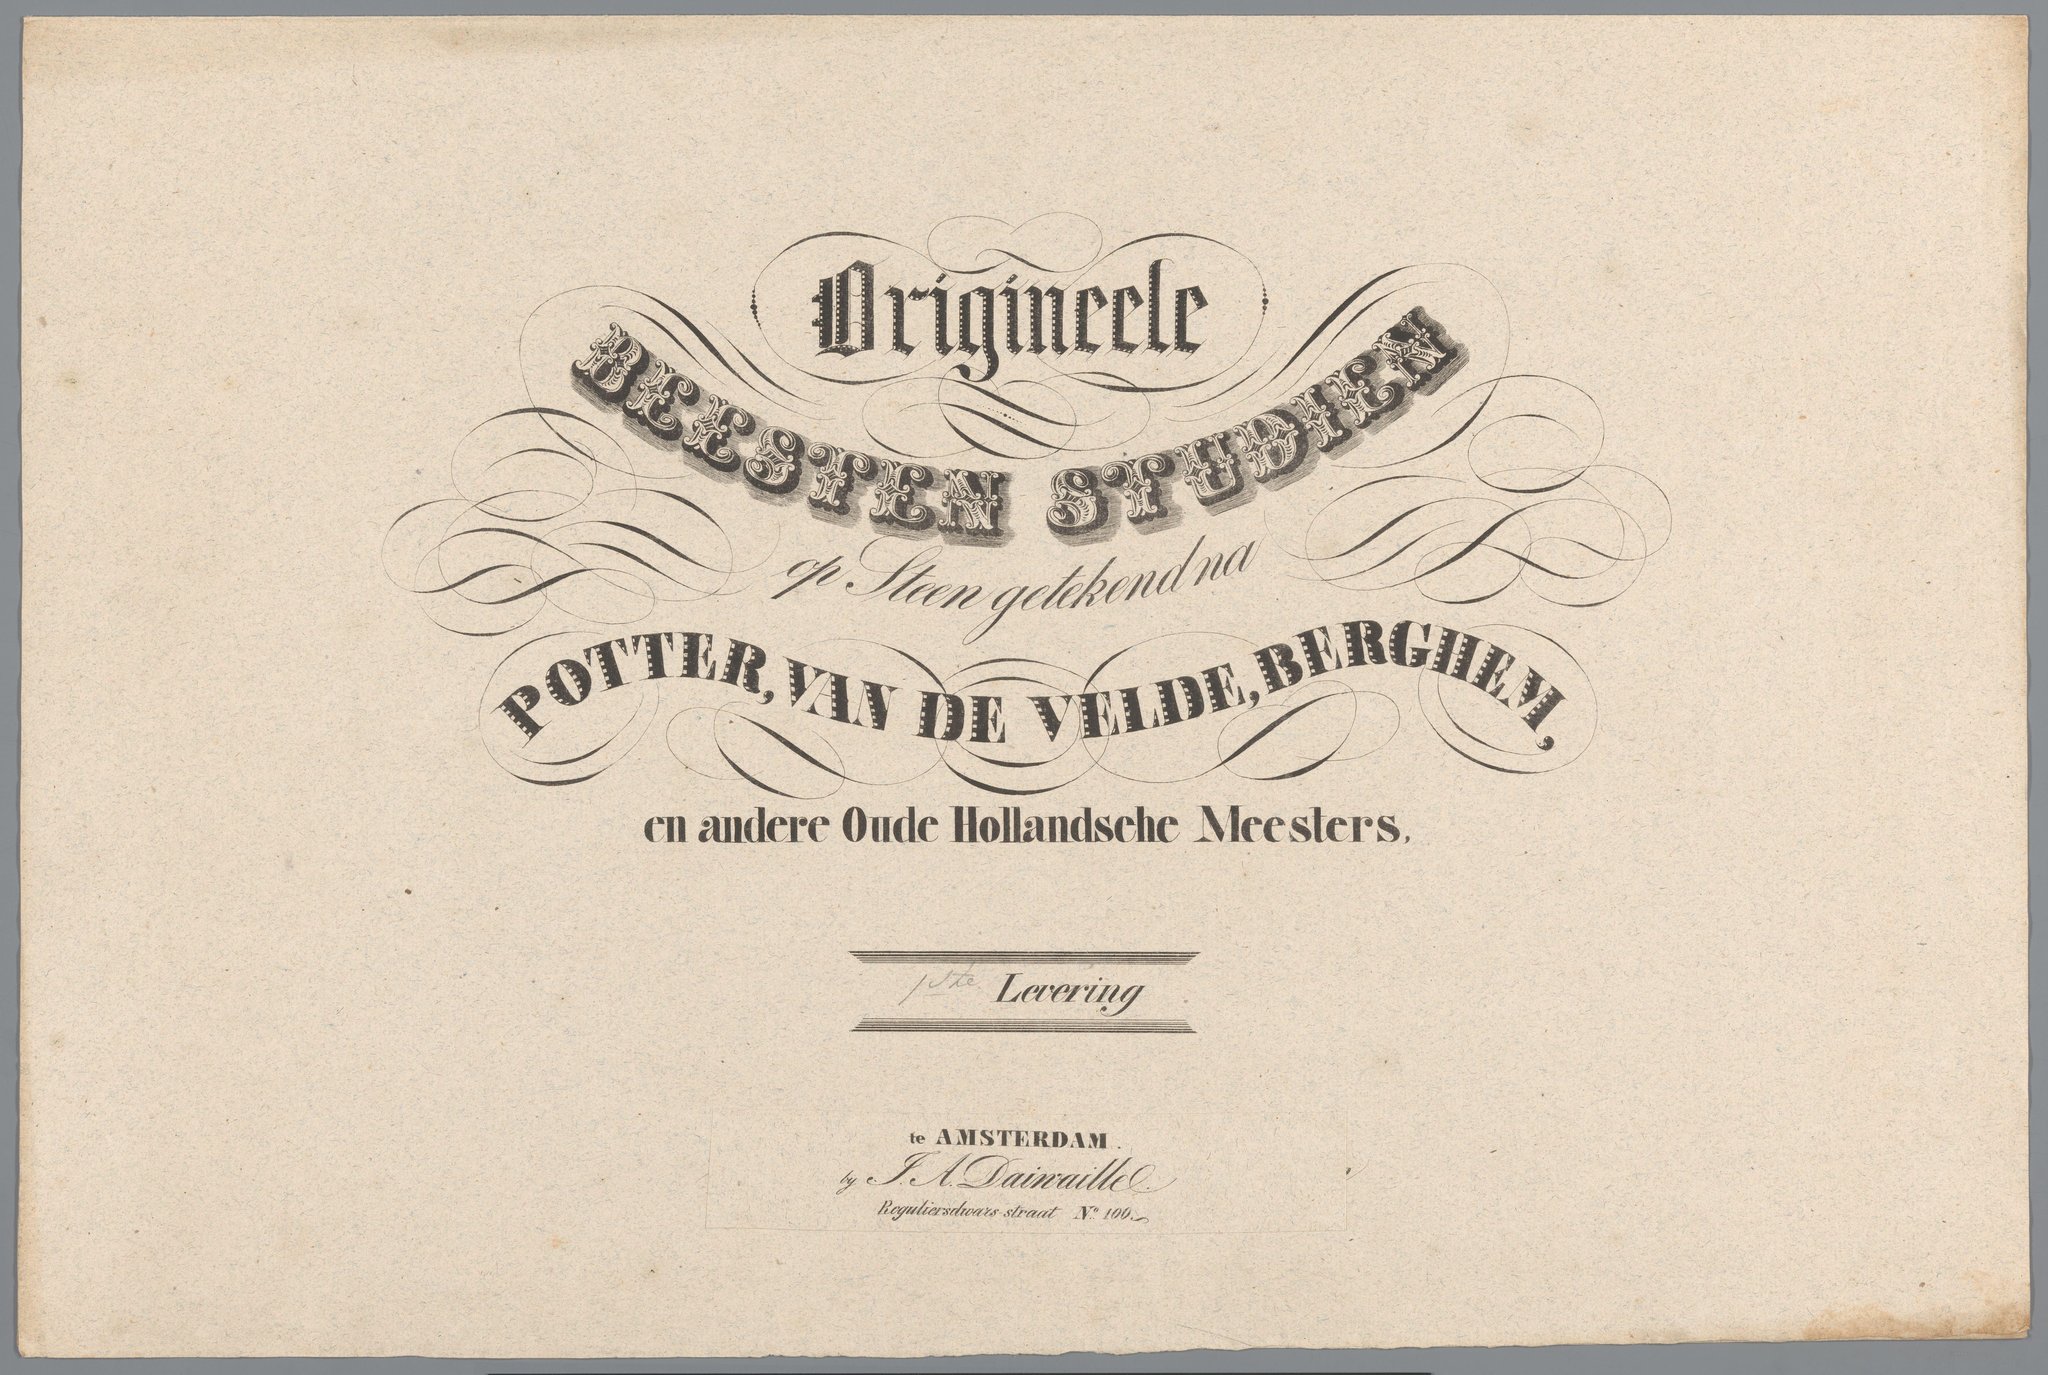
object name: wrapper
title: Omslag voor Origineele Beesten Studien op Steen getekend na Potter, Van de Velde, Berghem, en andere Oude Hollandsche Meesters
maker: jean augustin daiwaille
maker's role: draughtsman, print maker, printer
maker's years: 1786-1850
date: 1820-1833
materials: paper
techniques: lithograph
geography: amsterdam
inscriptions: inscription, inscription: ‘1ste’